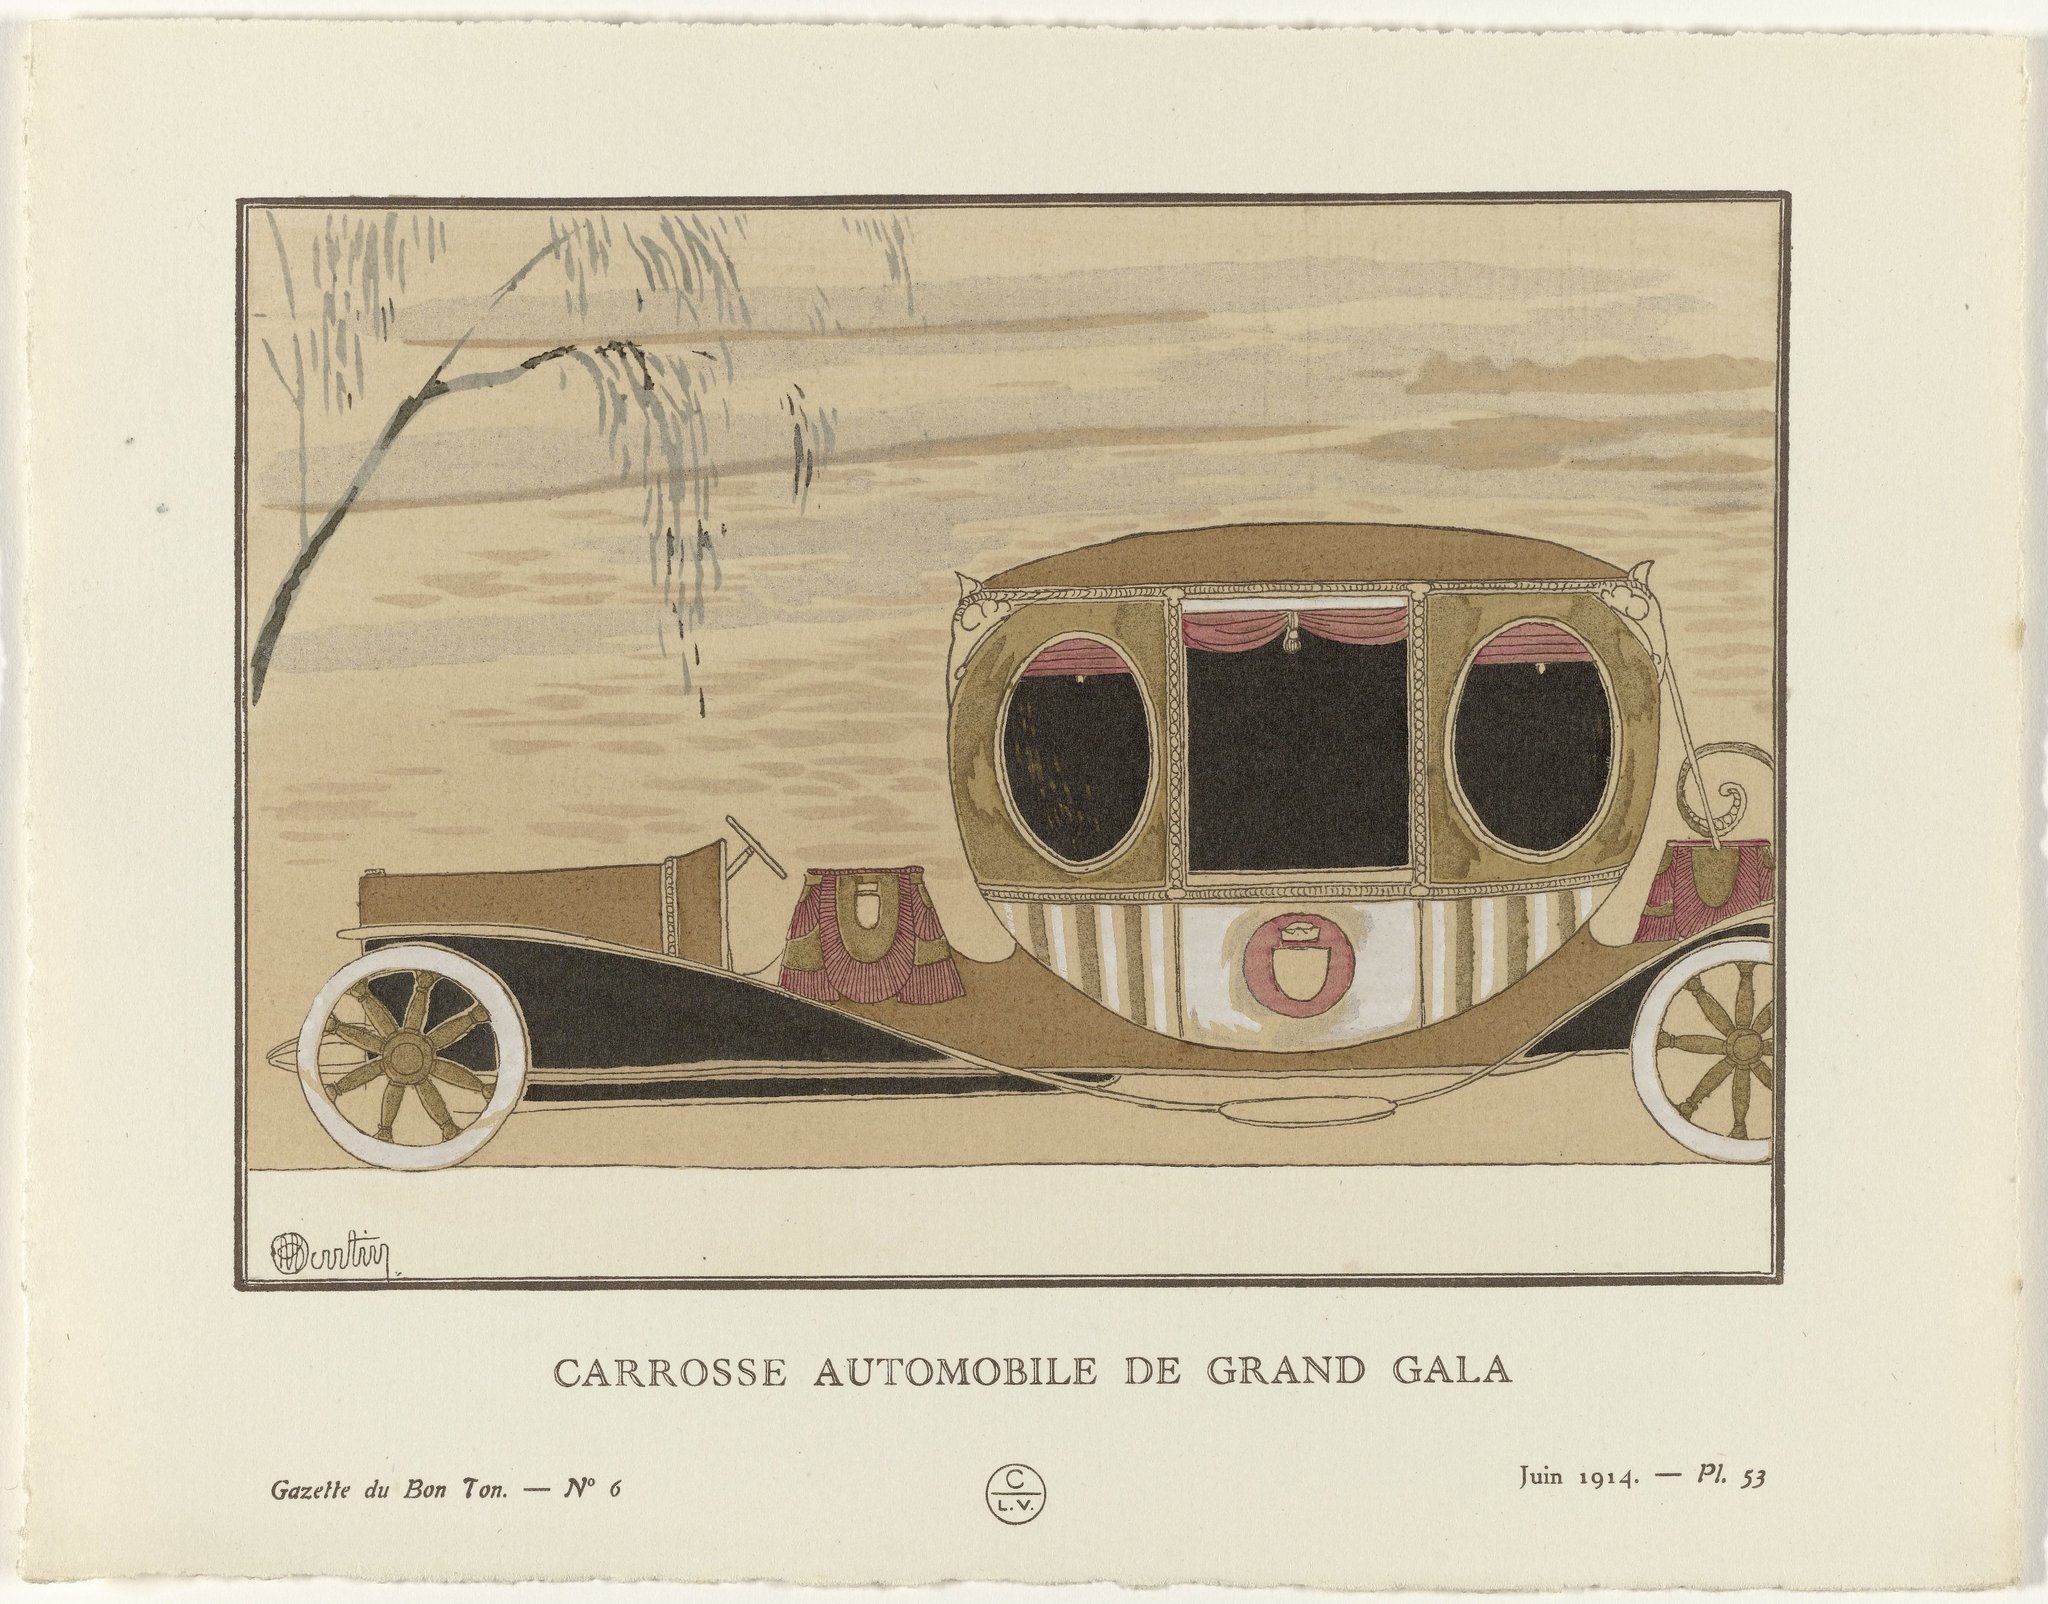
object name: fashion print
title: Gazette du Bon Ton, 1914 - No. 6, Pl. 53: Carrosse automobile de grand gala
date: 1914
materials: paper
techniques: hand coloring, letterpress printing, lithograph, pochoir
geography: paris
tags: fashion plates, automobile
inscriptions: date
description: Een auto in de vorm van een koets, geschikt voor een gala. Planche 53 uit Gazette du Bon Ton 1914, No. 6. Uitleg over de auto op pagina "Explication des Planches".